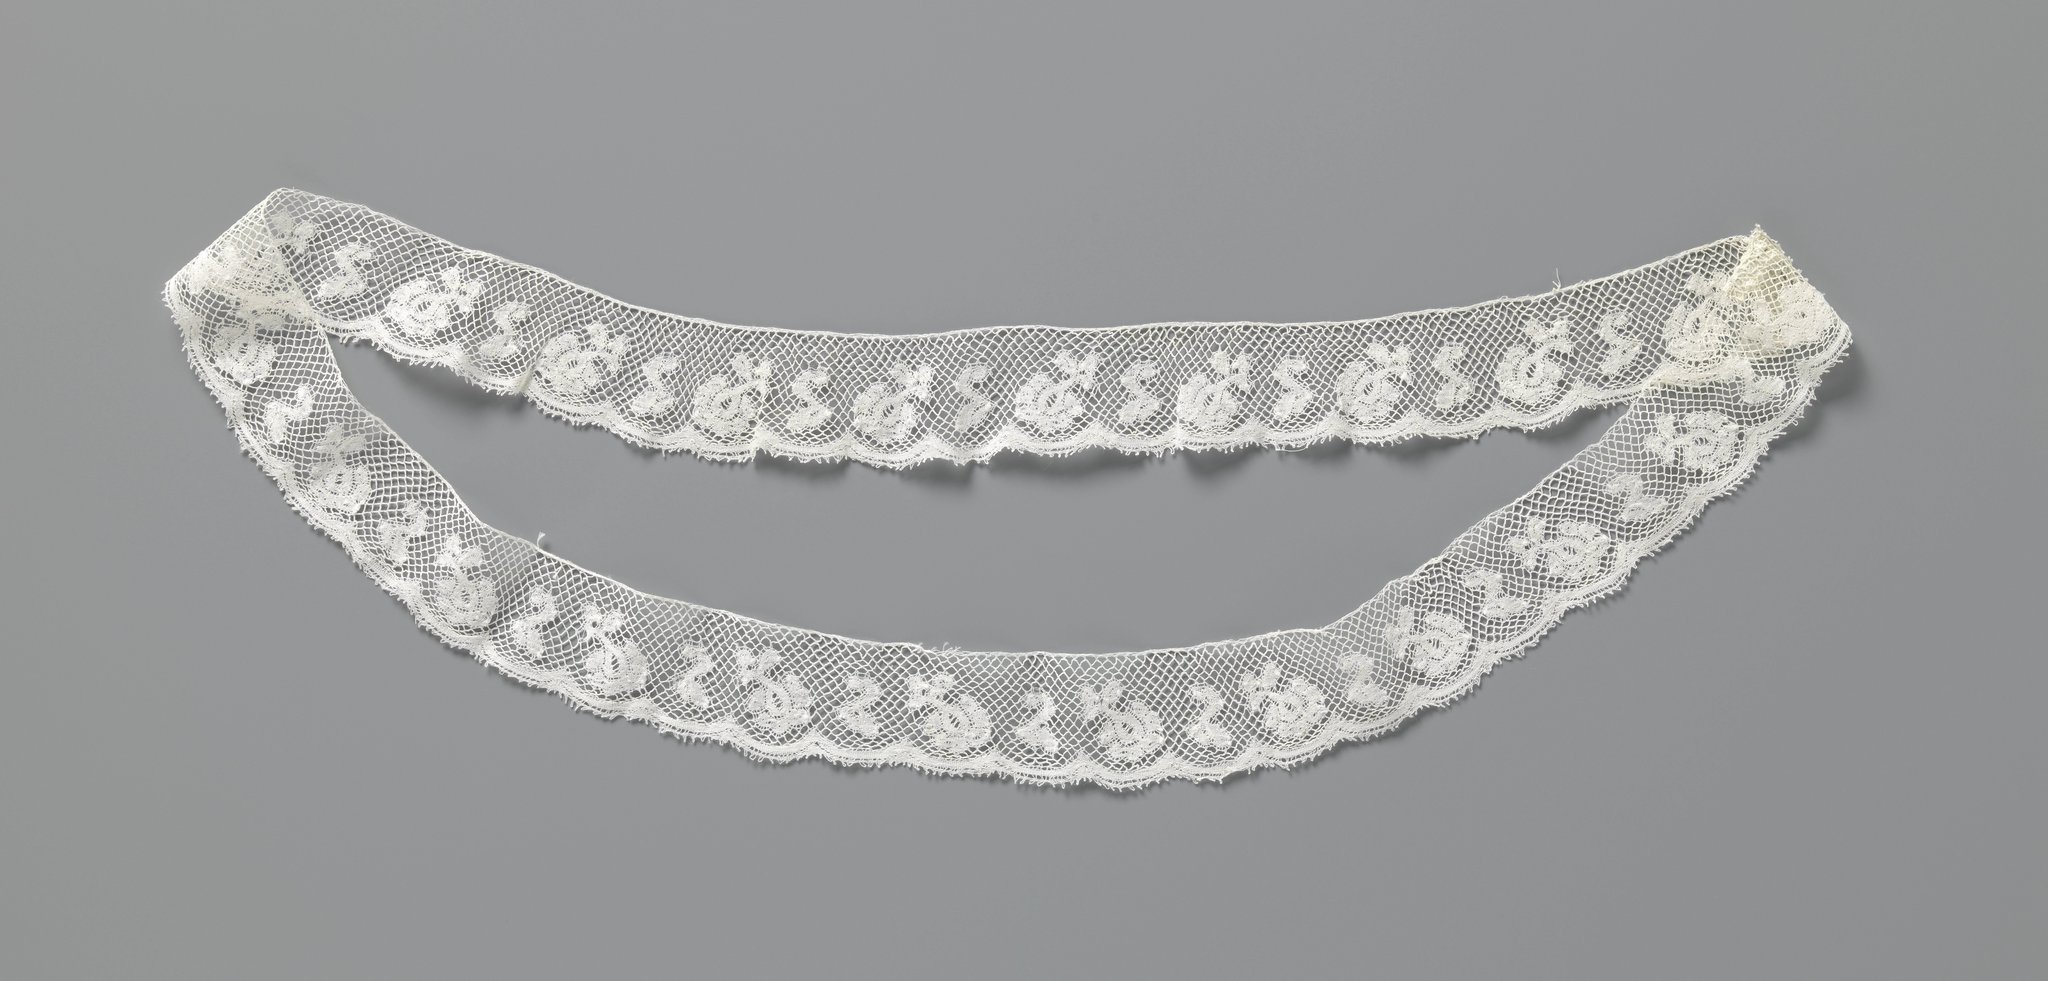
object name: strip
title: Mouwstrook van kloskant met losse roosjes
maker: Anonymous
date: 1910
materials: linen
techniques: lace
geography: netherlands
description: Op een fond van vierkante mazen staan, boven kleine gladde schulpjes, afwisselend losse roosjes en takjes in de vorm van vraagtekens. Valenciennes-kant.